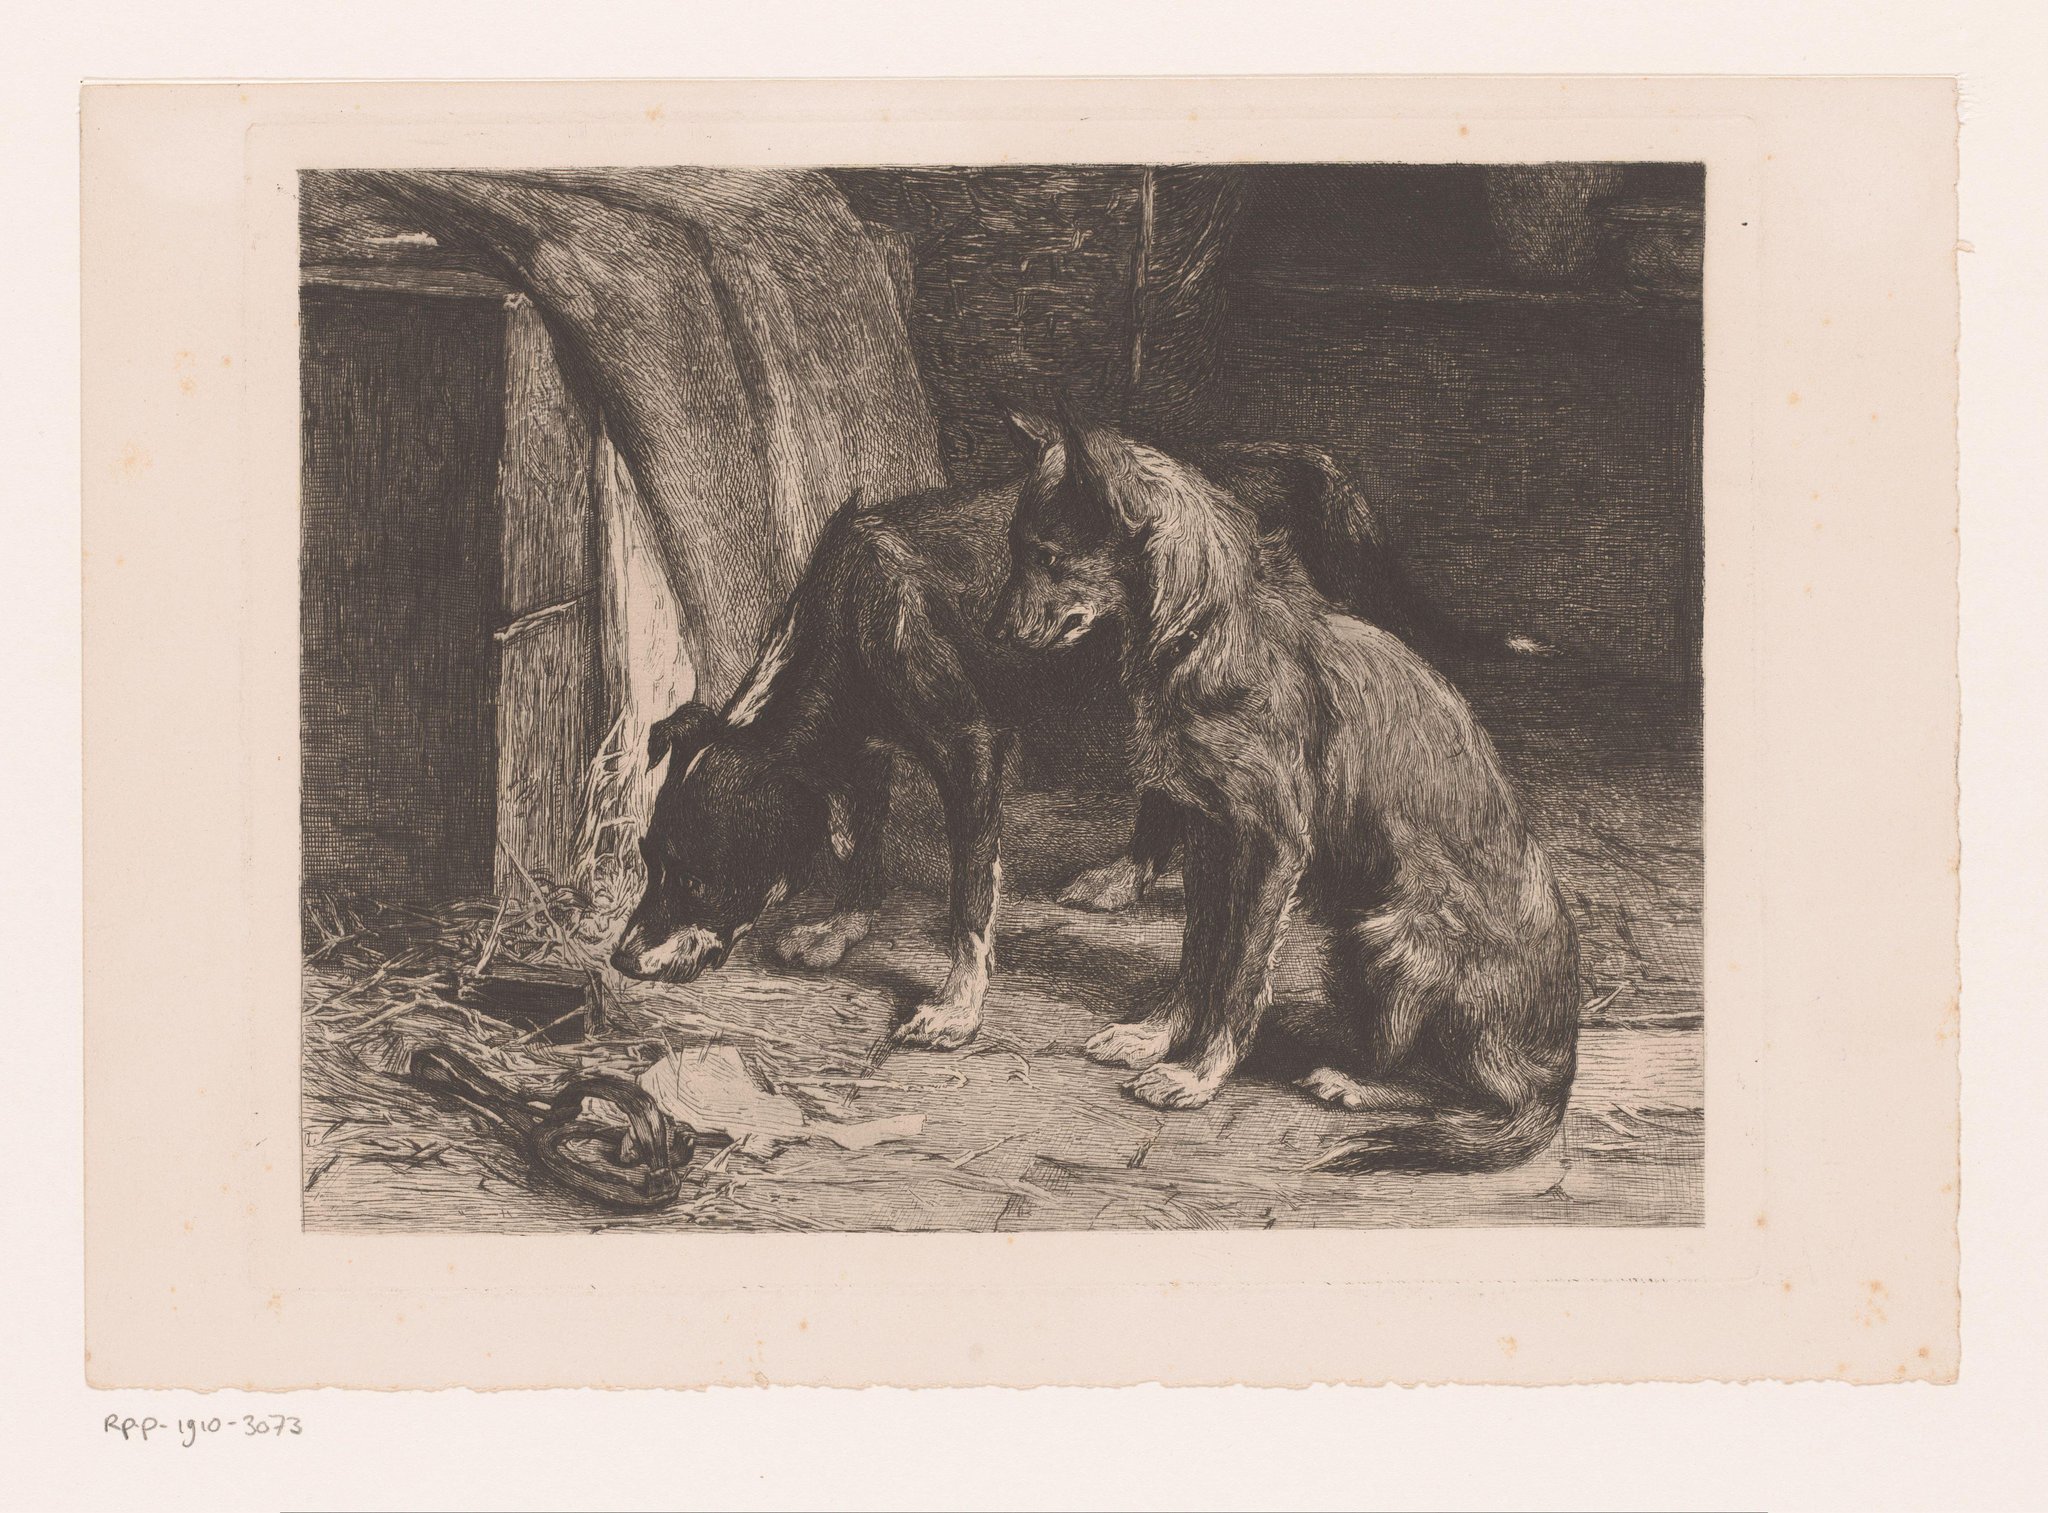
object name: print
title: Twee honden bij een rattenval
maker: van den eyken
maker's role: print maker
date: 1875-1899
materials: paper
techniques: etching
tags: mouse trap, dog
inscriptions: collector's mark: Lugt 2228